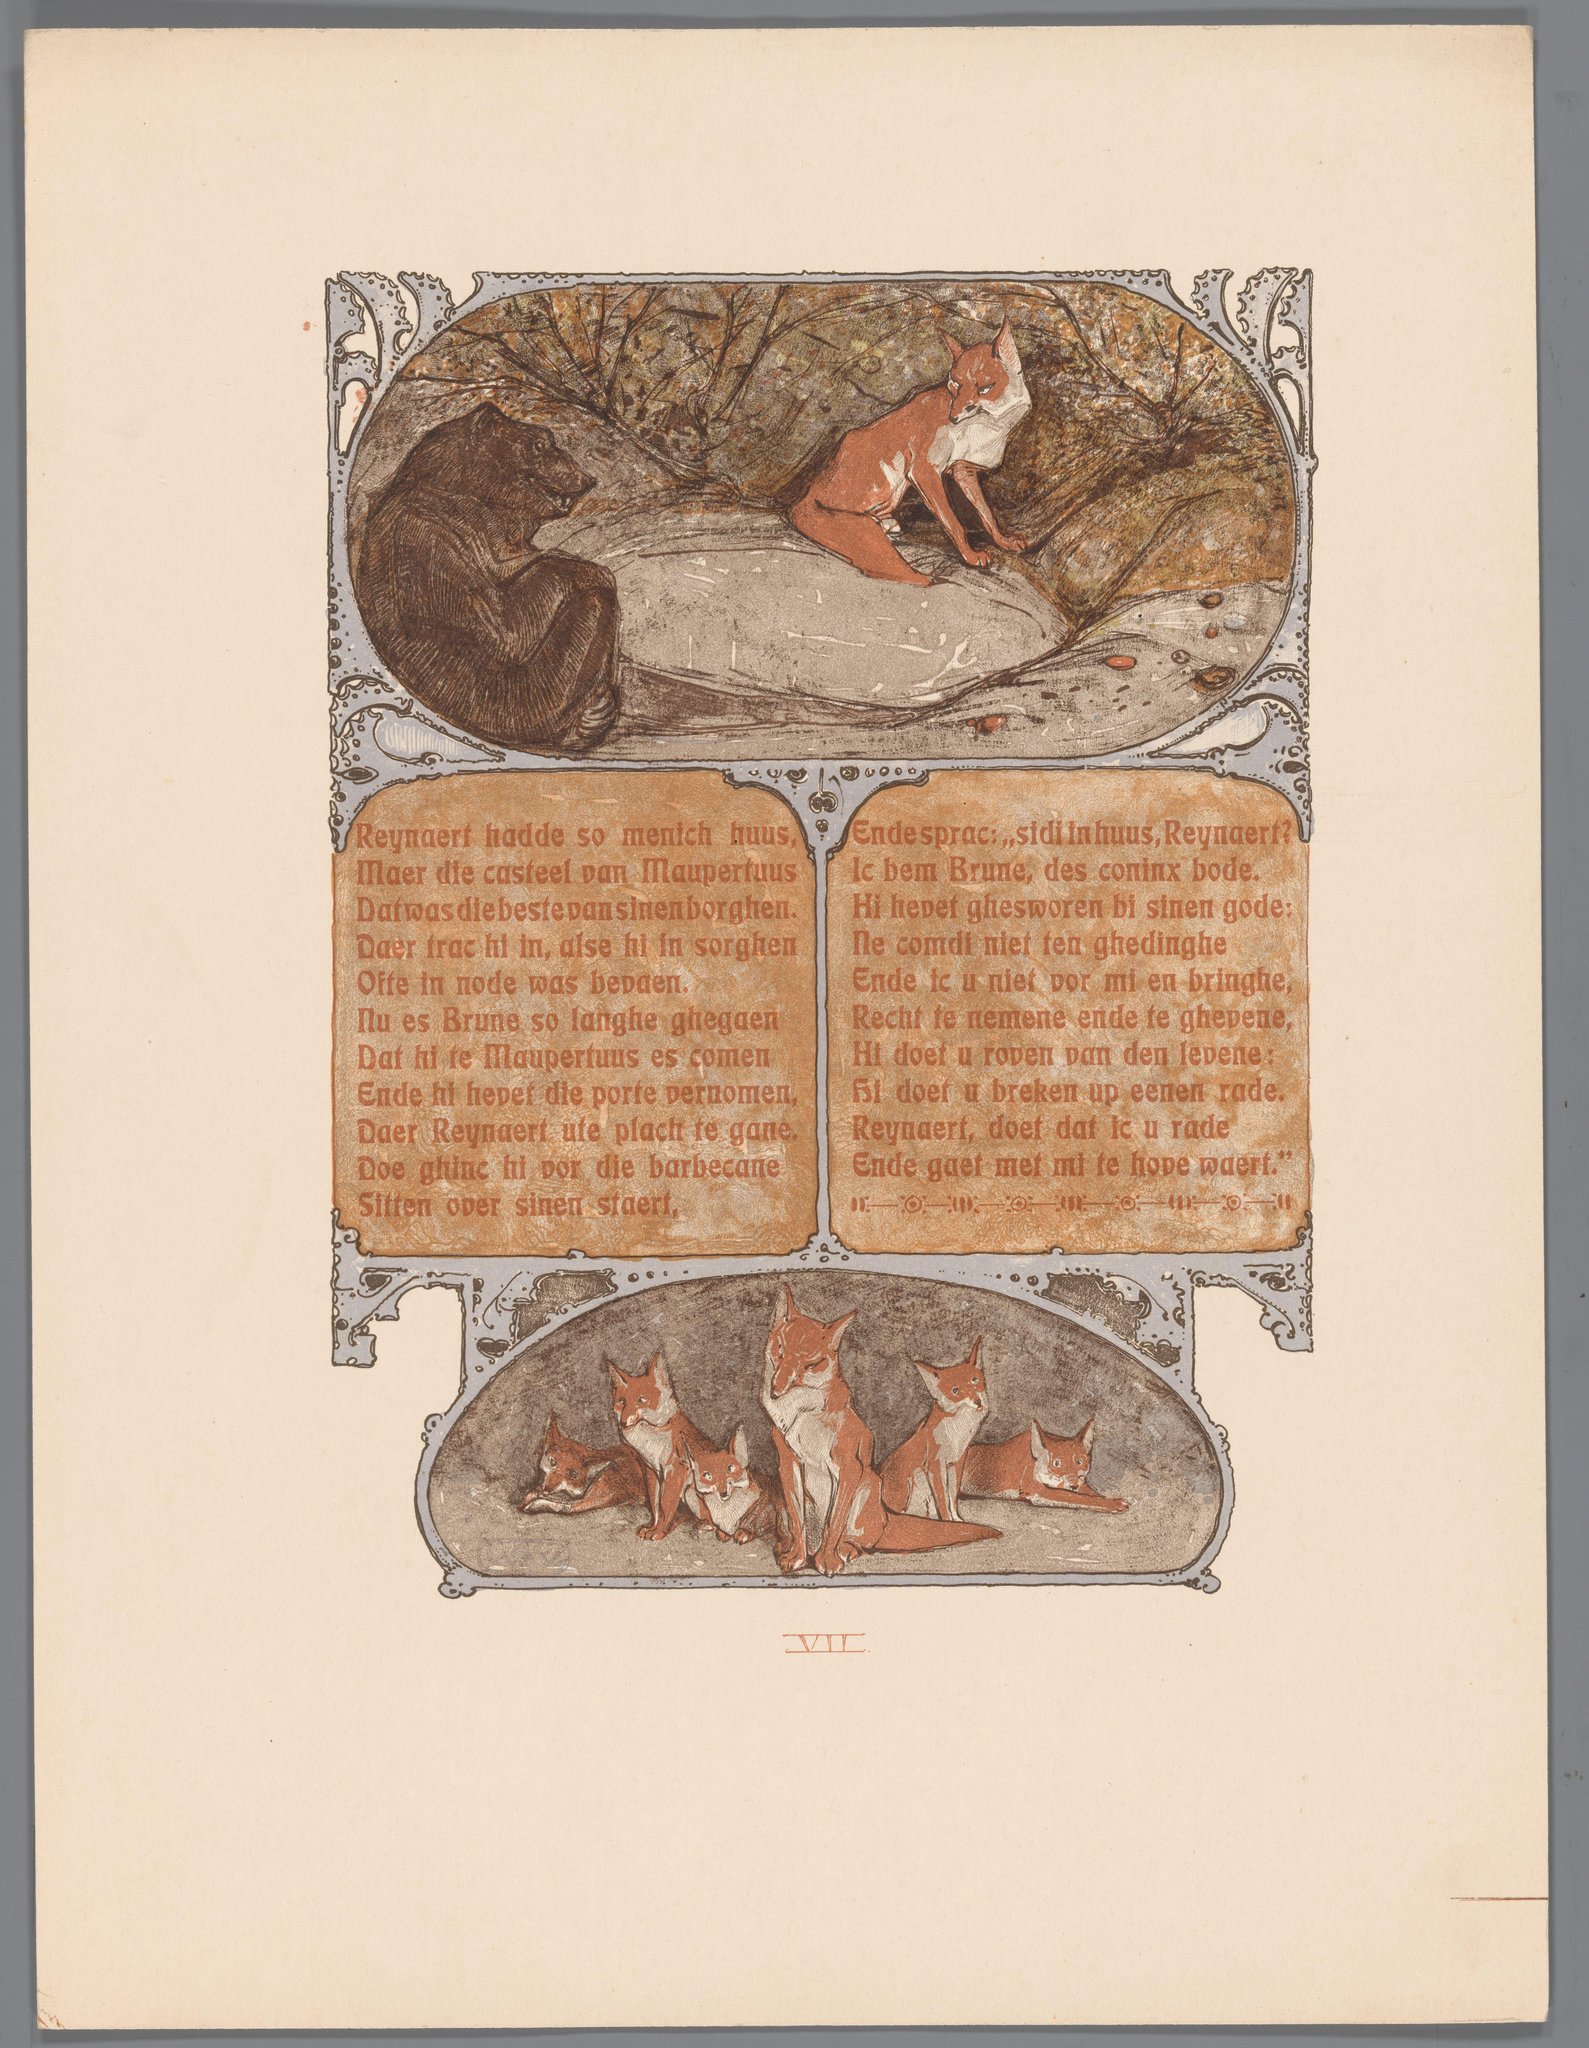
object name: book illustration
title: Beer (Bruun) en vos (Reinaert)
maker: bernard willem wierink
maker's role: draughtsman, print maker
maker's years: 1856-1939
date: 1910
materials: paper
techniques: lithograph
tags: fable of reynard the fox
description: Prent gebruikt in: Streuvels, Stijn (Frank Lateur). Reinaert de Vos naar verschillende uitgaven van het middeleeuwsche epos. Amsterdam: L.J. Veen, 1910.